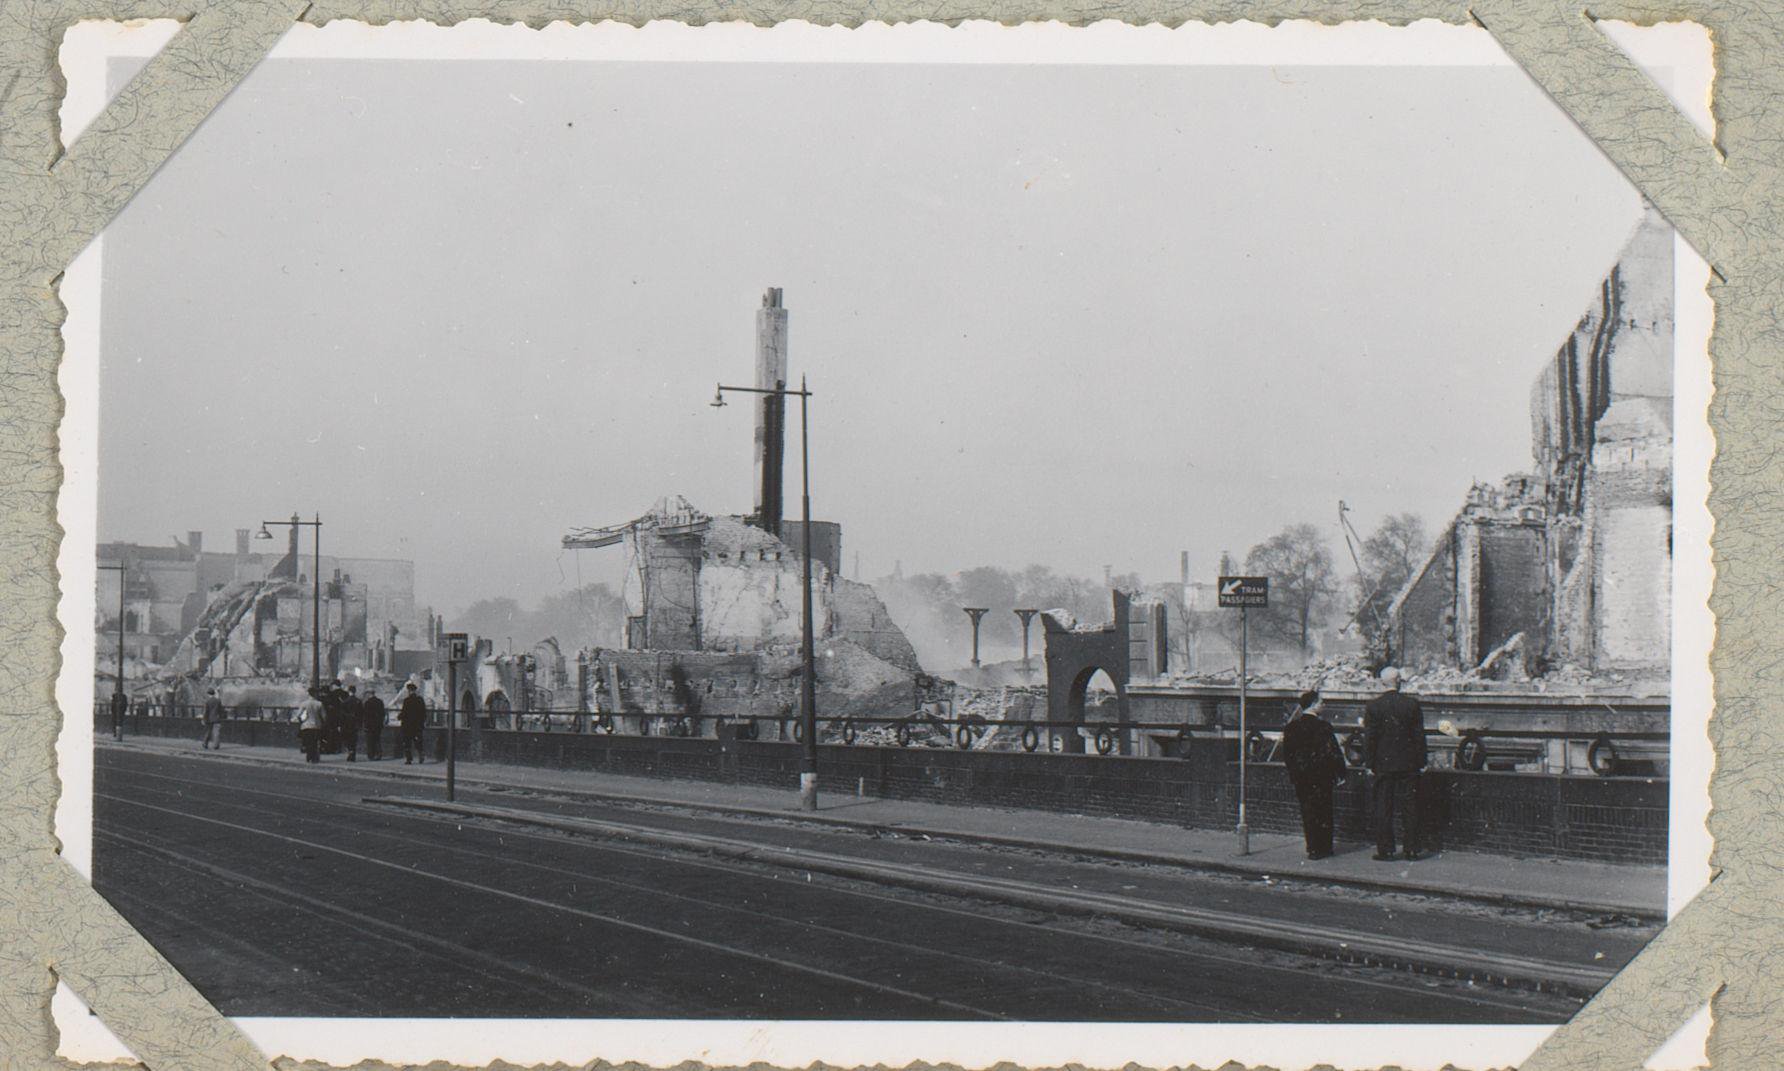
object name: photograph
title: Ruïnes rond de brug bij de Boompjes te Rotterdam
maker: j. nolte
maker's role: fotograaf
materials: photographic support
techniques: gelatin silver print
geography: rotterdam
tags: devastated, ruined place or city (~ warfare), rotterdam blitz